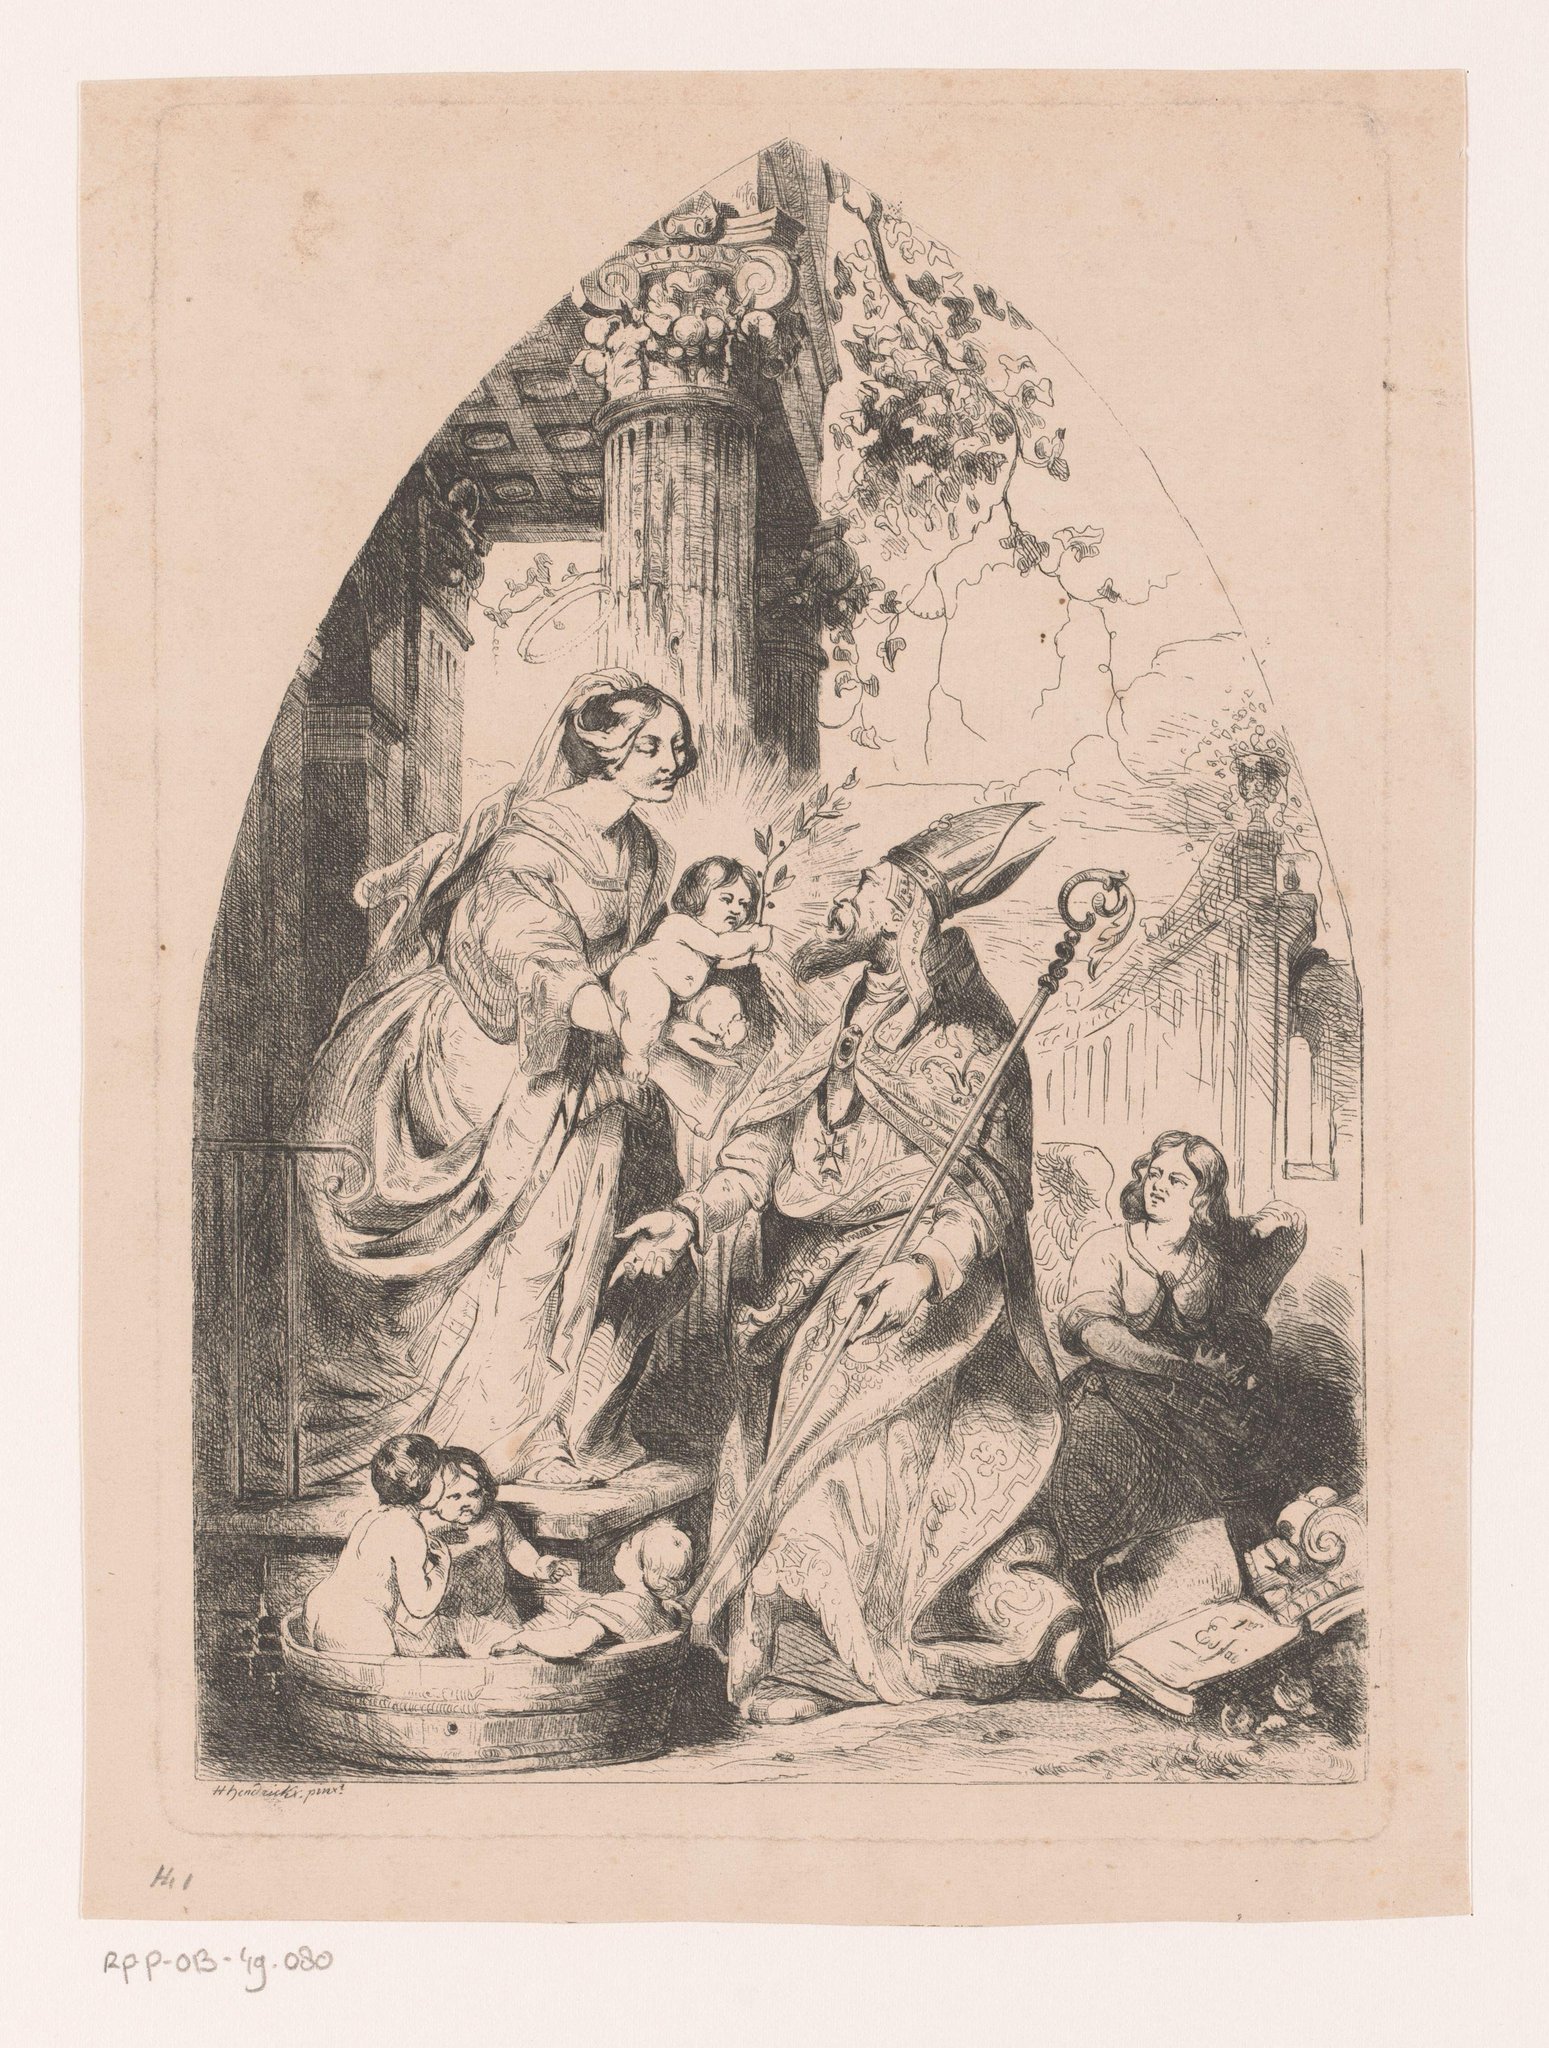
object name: print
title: Sint Nicolaas in aanbidding voor het Christuskind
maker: henri hendrickx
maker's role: print maker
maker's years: 1817-1894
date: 1827-1894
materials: paper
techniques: etching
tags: madonna: i.e. mary with the christ-child, the bishop nicholas of myra (or bari); possible attributes: anchor, boat, three golden balls (on a book), three purses, three children in a tub, three maidens, angels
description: Sint Nicolaas aanbid Maria en kind. Linksonder zijn drie kinderen in een ton afgebeeld, verwijzend naar een van de wonderen van Sint Nicolaas. Op de achtergrond klassieke architectuur.